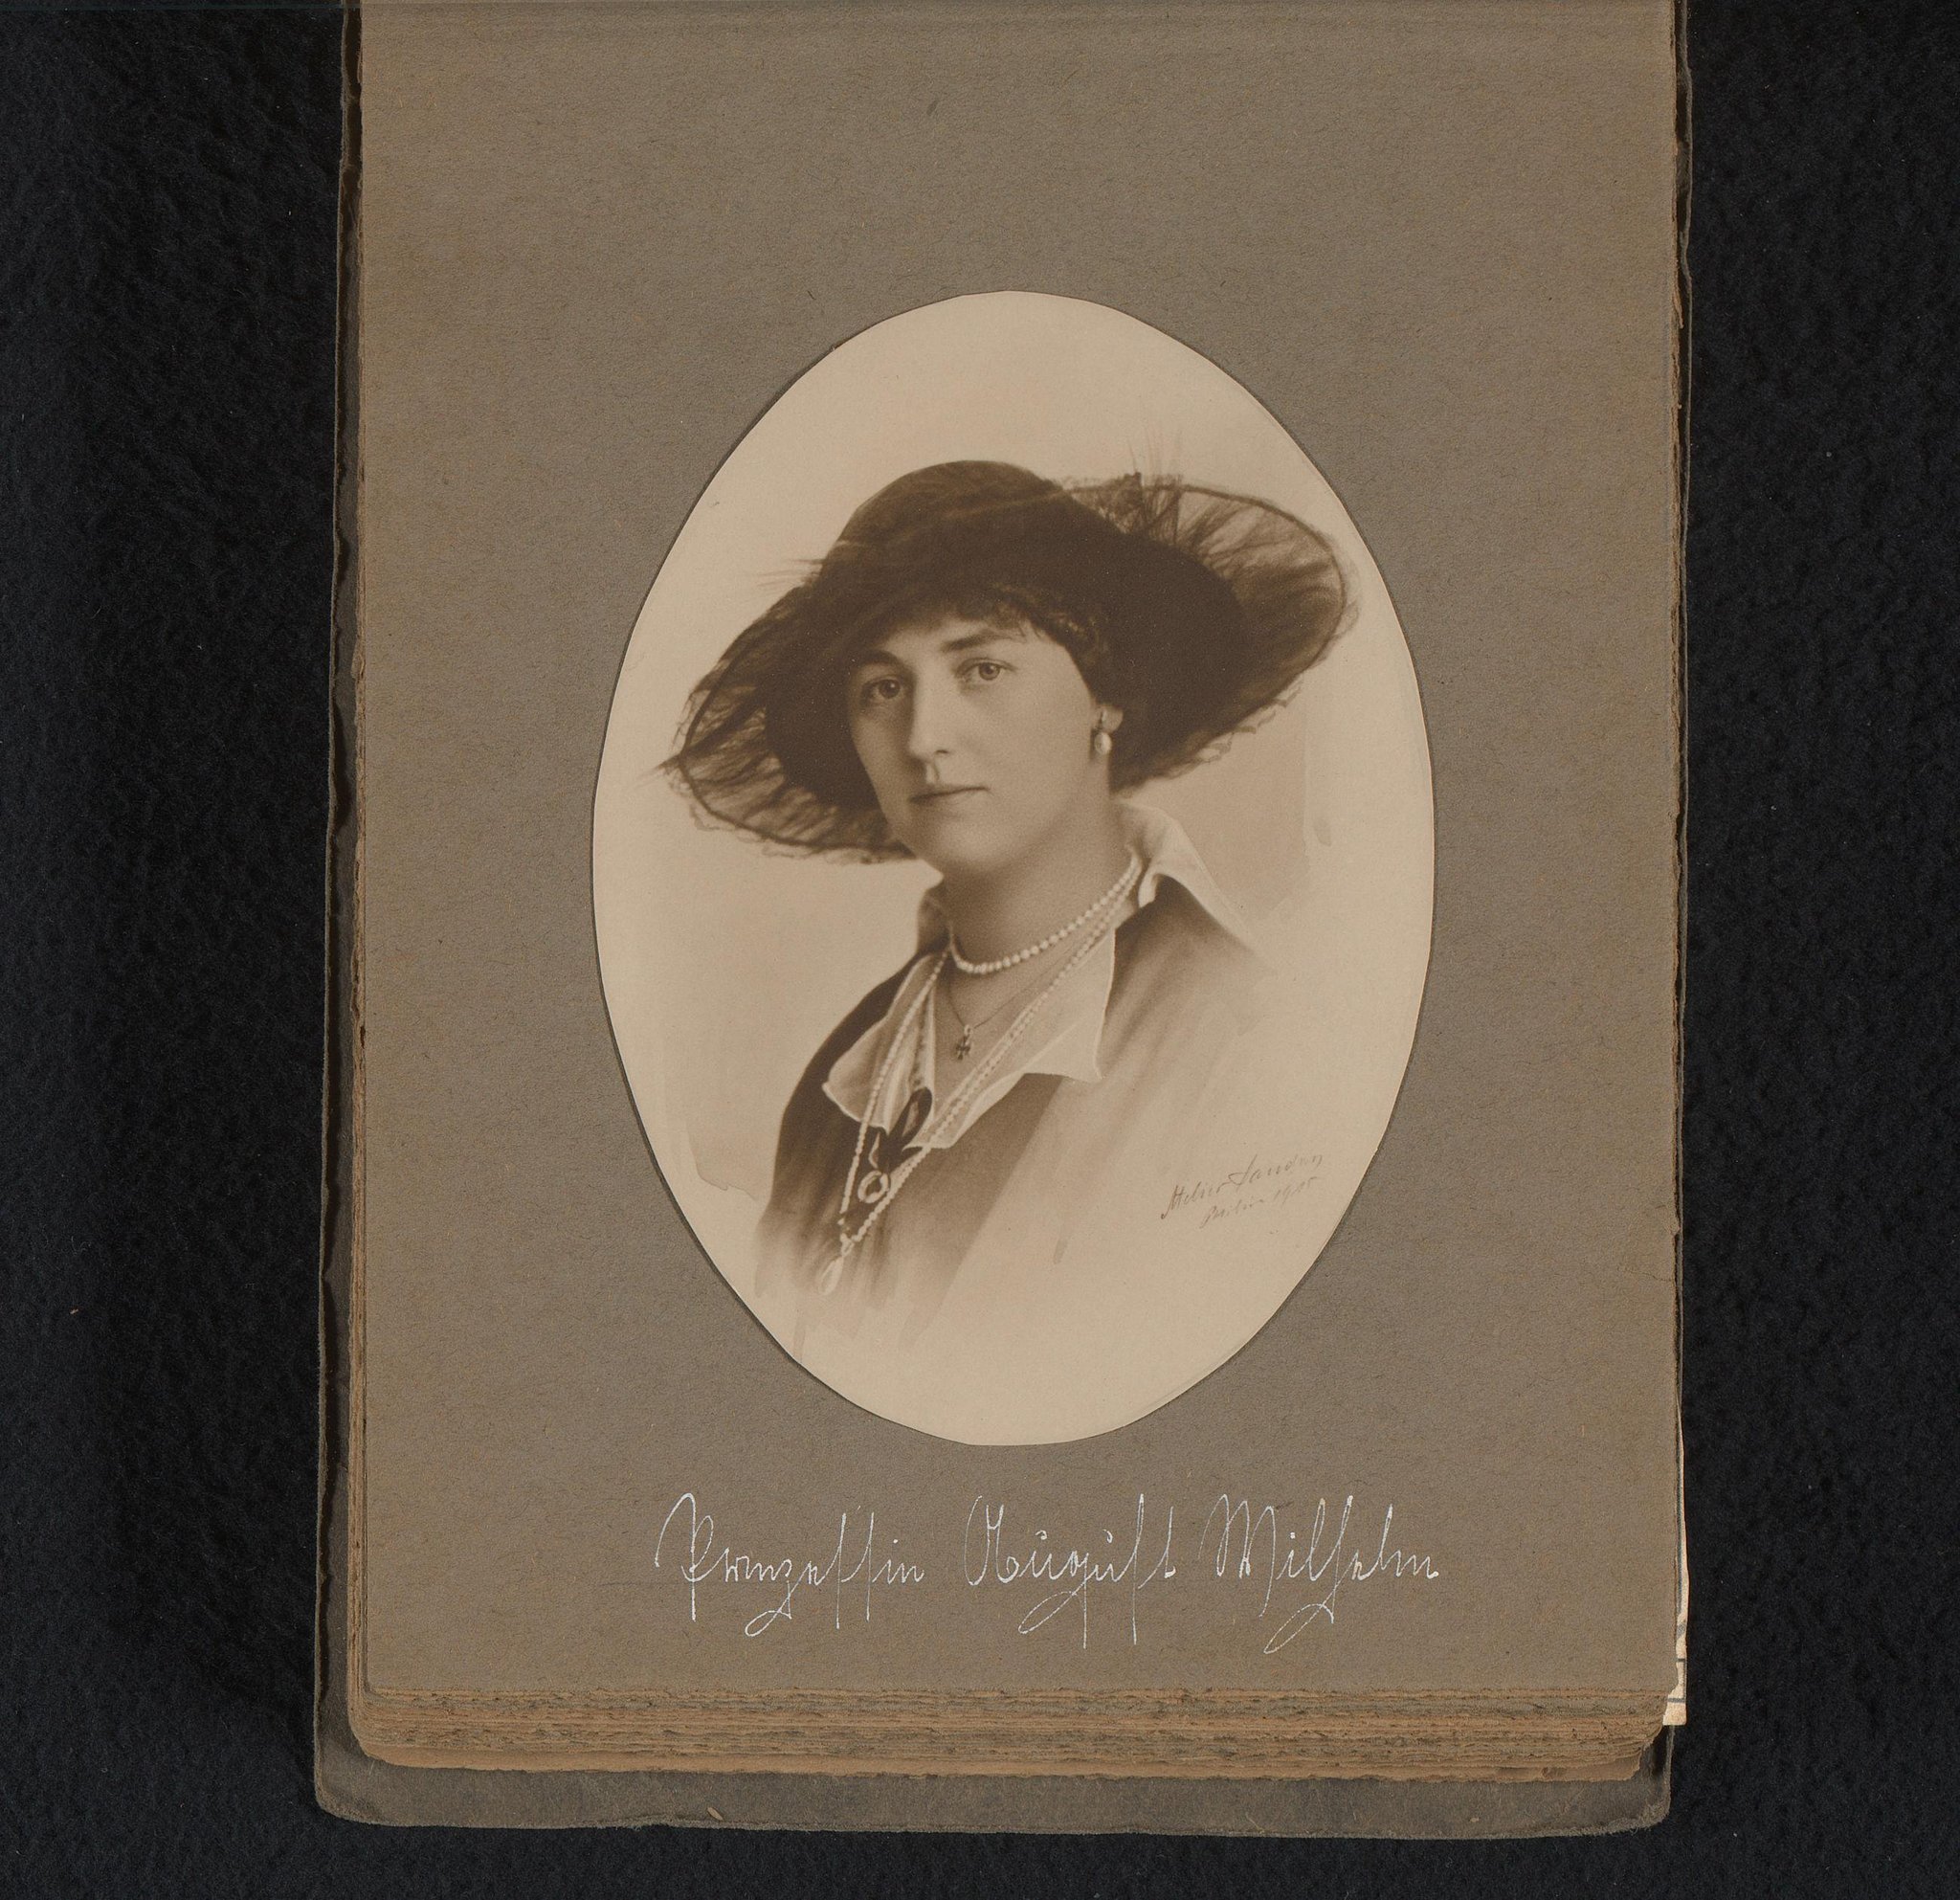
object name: album leaf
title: Portret van Alexandra Victoria Auguste Leopoldine Charlotte Amalie Wilhelmina van Sleeswijk-Holstein-Sonderburg-Glücksburg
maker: Anonymous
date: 1910-1917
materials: paper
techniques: gelatin silver print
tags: lyon, historical persons, princess